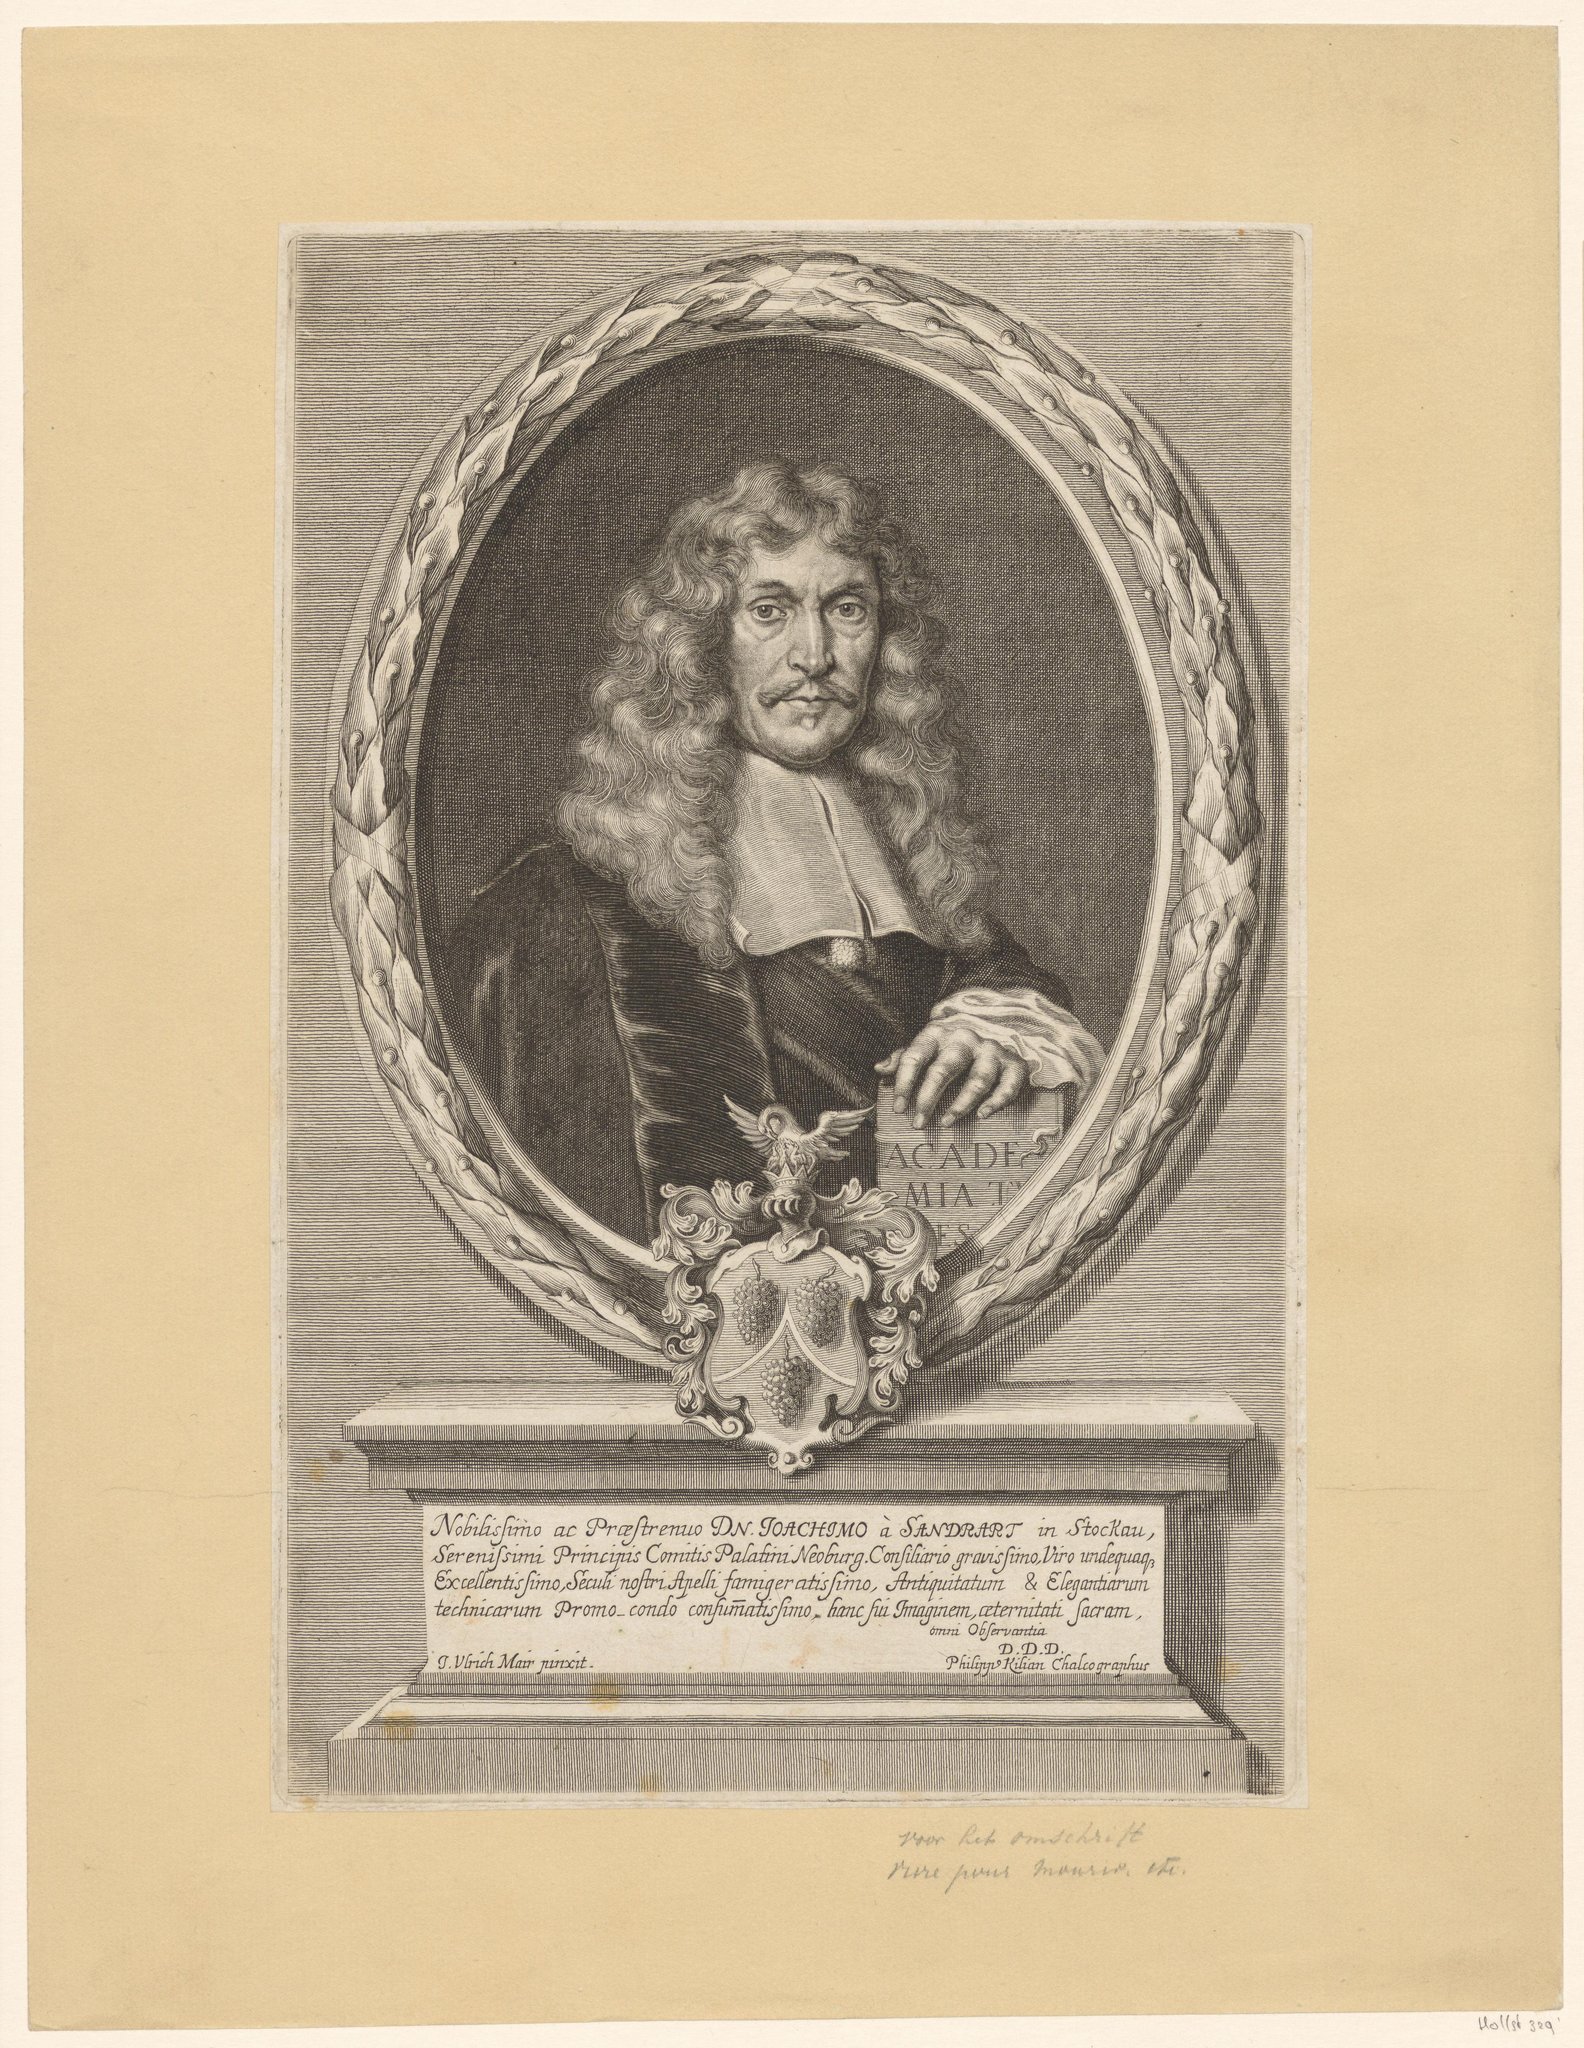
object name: print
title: Portret van Joachim von Sandrart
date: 1653-1693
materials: paper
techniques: engraving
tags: painter, print maker, draughtsman, joachim von sandrart (i), historical persons, portrait, self-portrait of painter, ornament ~ festoon, garland